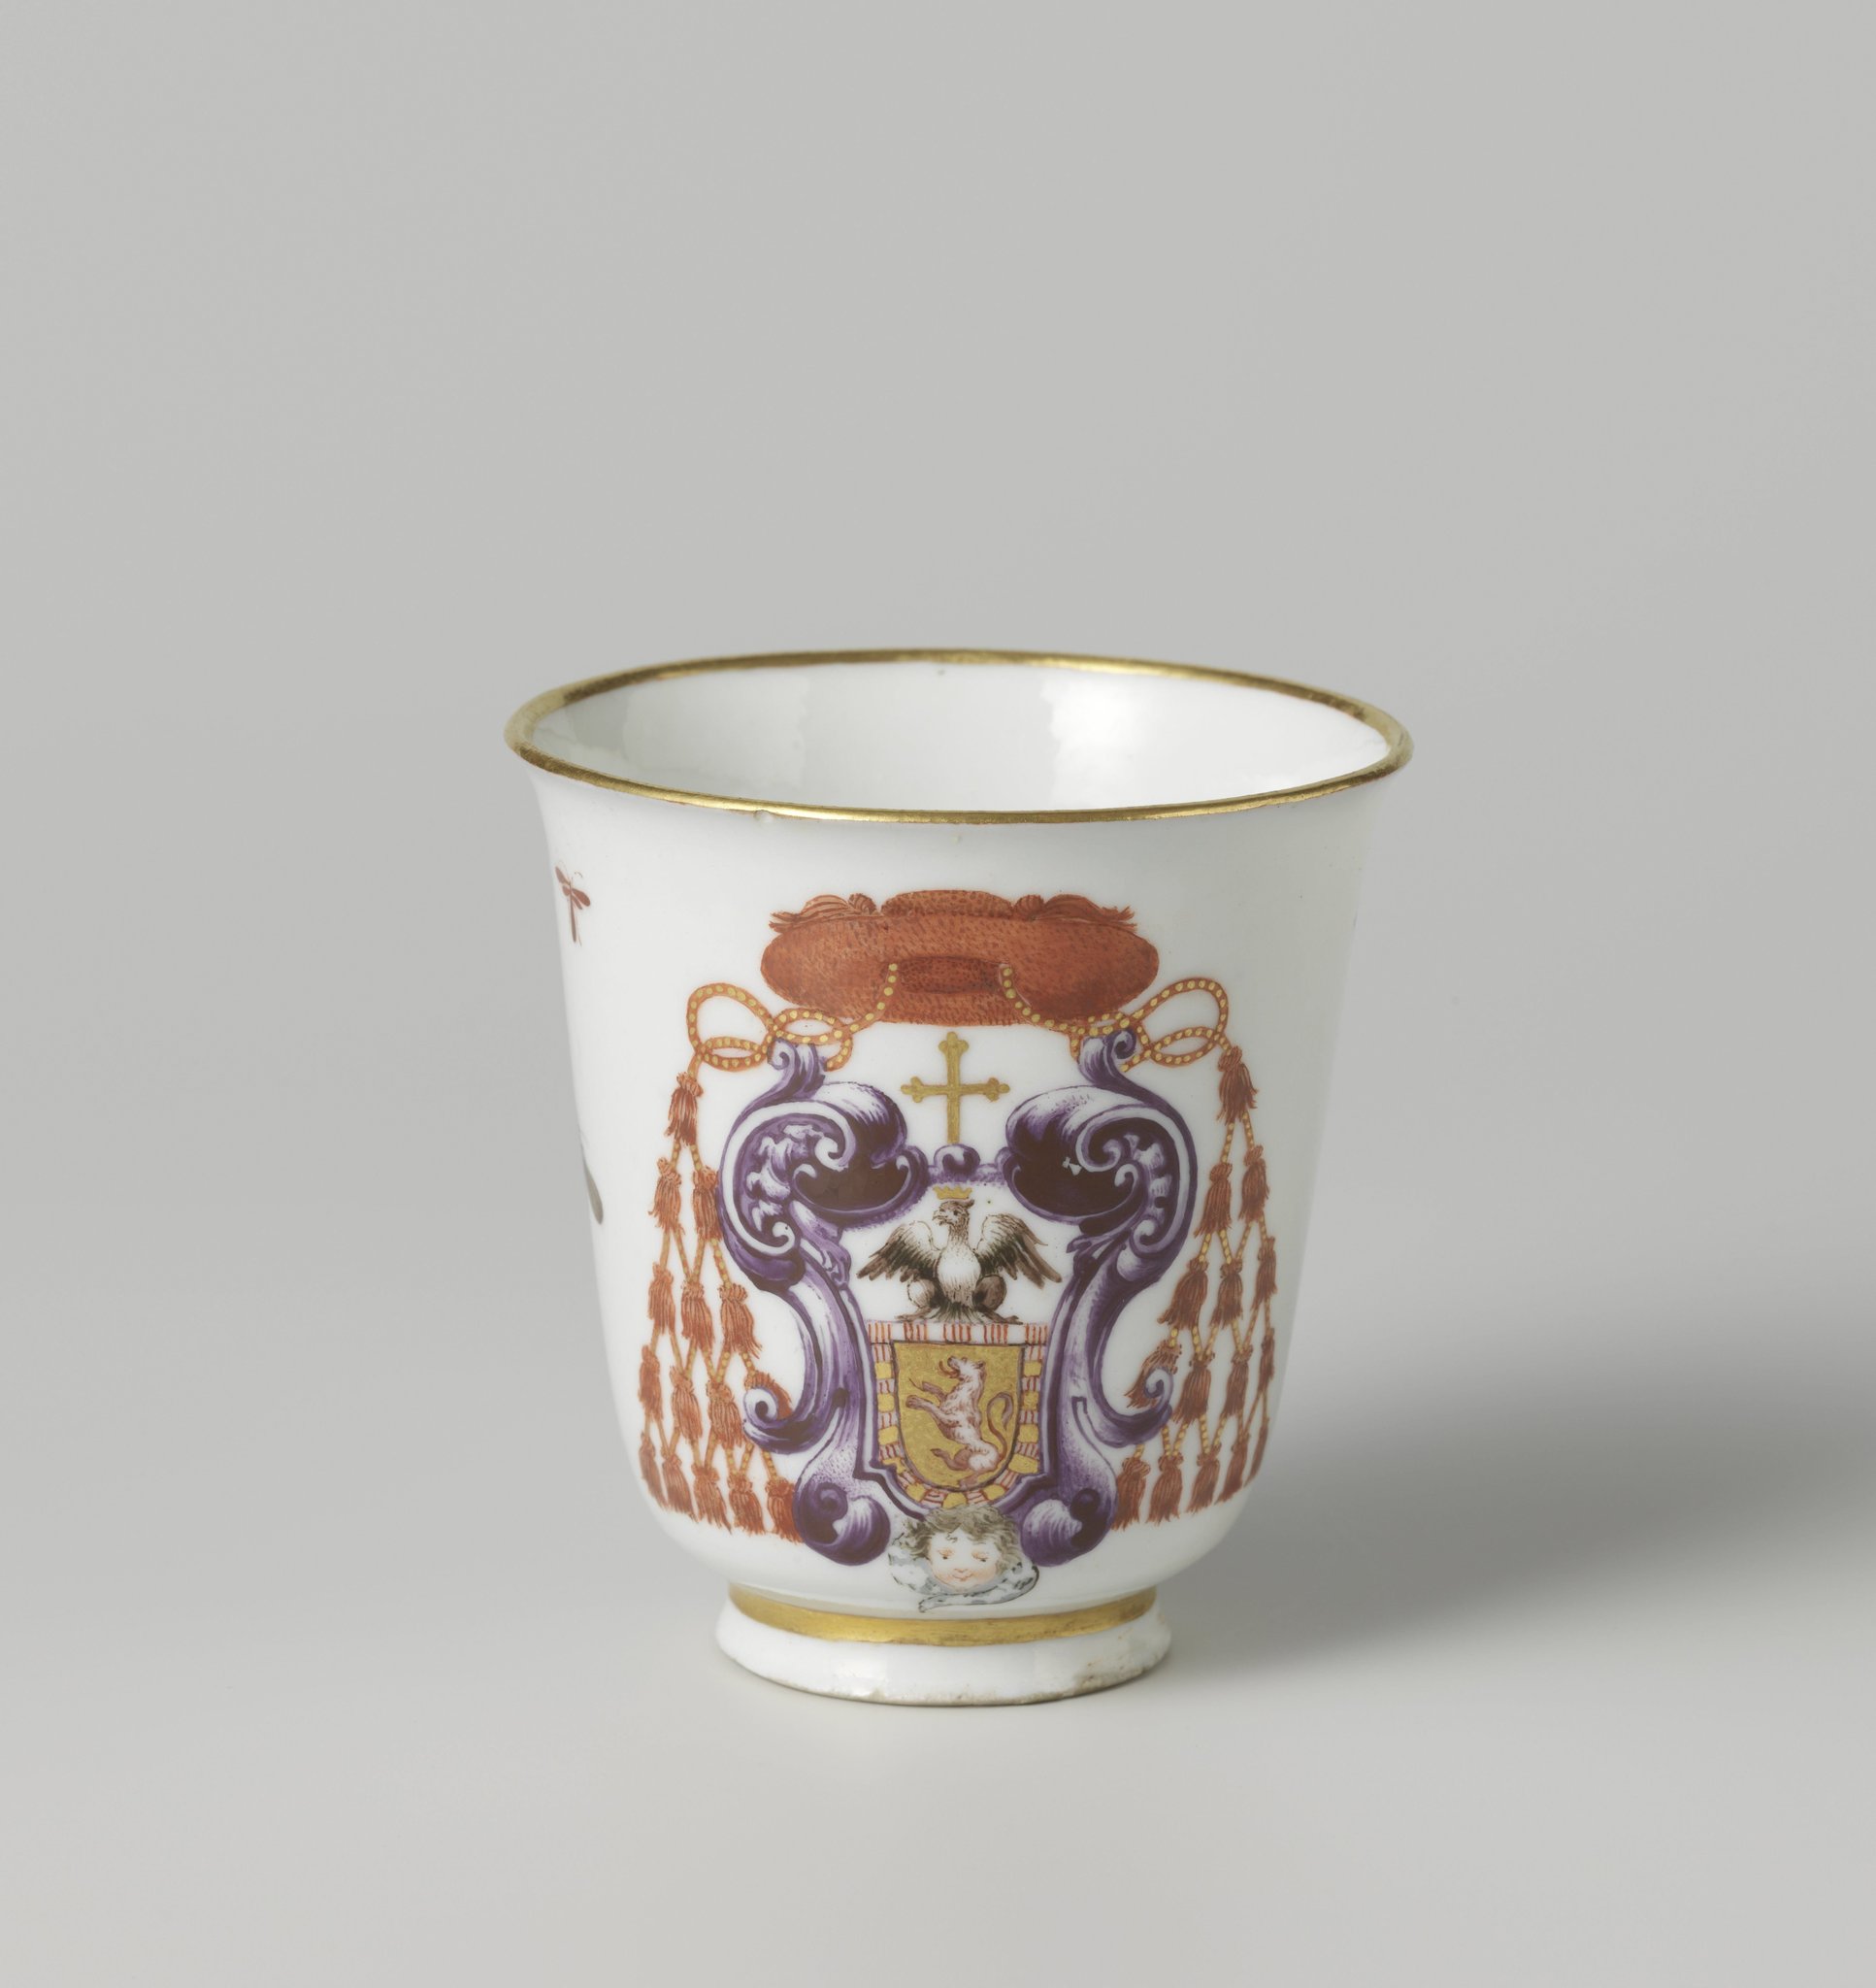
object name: cup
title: Cup with the coat of arms of cardinal Giovanni Francesco Stoppani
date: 1752-1753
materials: glaze, gold, paint, porcelain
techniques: firing, gilding, turning, vitrification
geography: doccia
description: Cup with the arms of Cardinal Giovanni Francisco Stoppani (1696 - 1774). Porcelain. Doccia (Italy), 1752 - 1753. Factory of Carlo Ginori. Part of a coffee service presented to the Cardinal by Ginori. J.G.A.N. de Vries bequest, 1925.